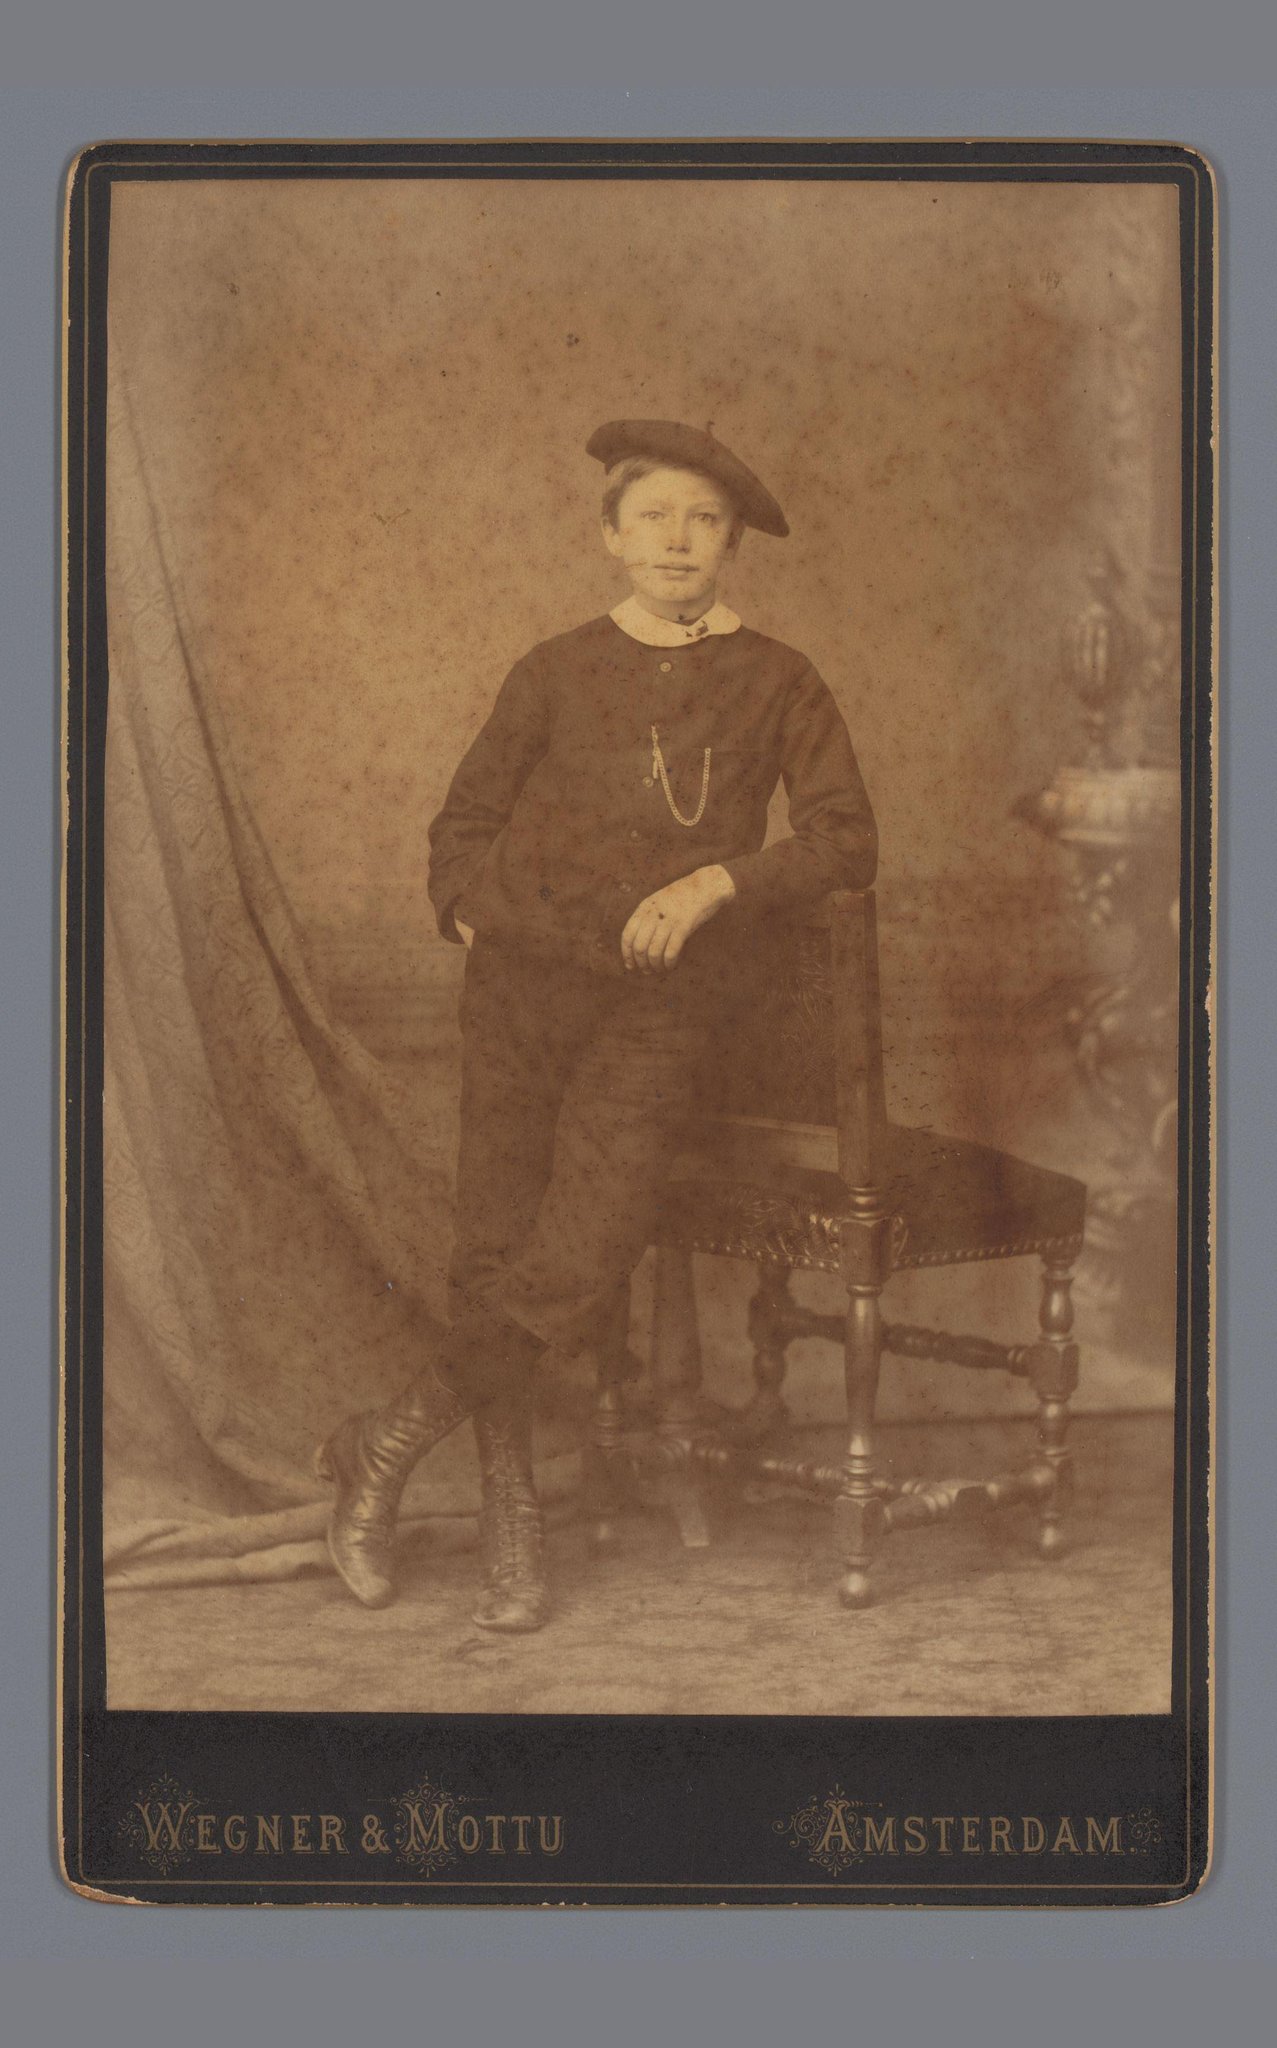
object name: cabinet photograph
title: Portret van een onbekende jongen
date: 1875-1900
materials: cardboard, photographic support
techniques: albumen print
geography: amsterdam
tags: historical persons, amsterdam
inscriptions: workshop stamp: ‘Photographisch Artistisch Atelier/ van Wegner & Mottu/ Rokin over de Bank 138, Amsterdam’